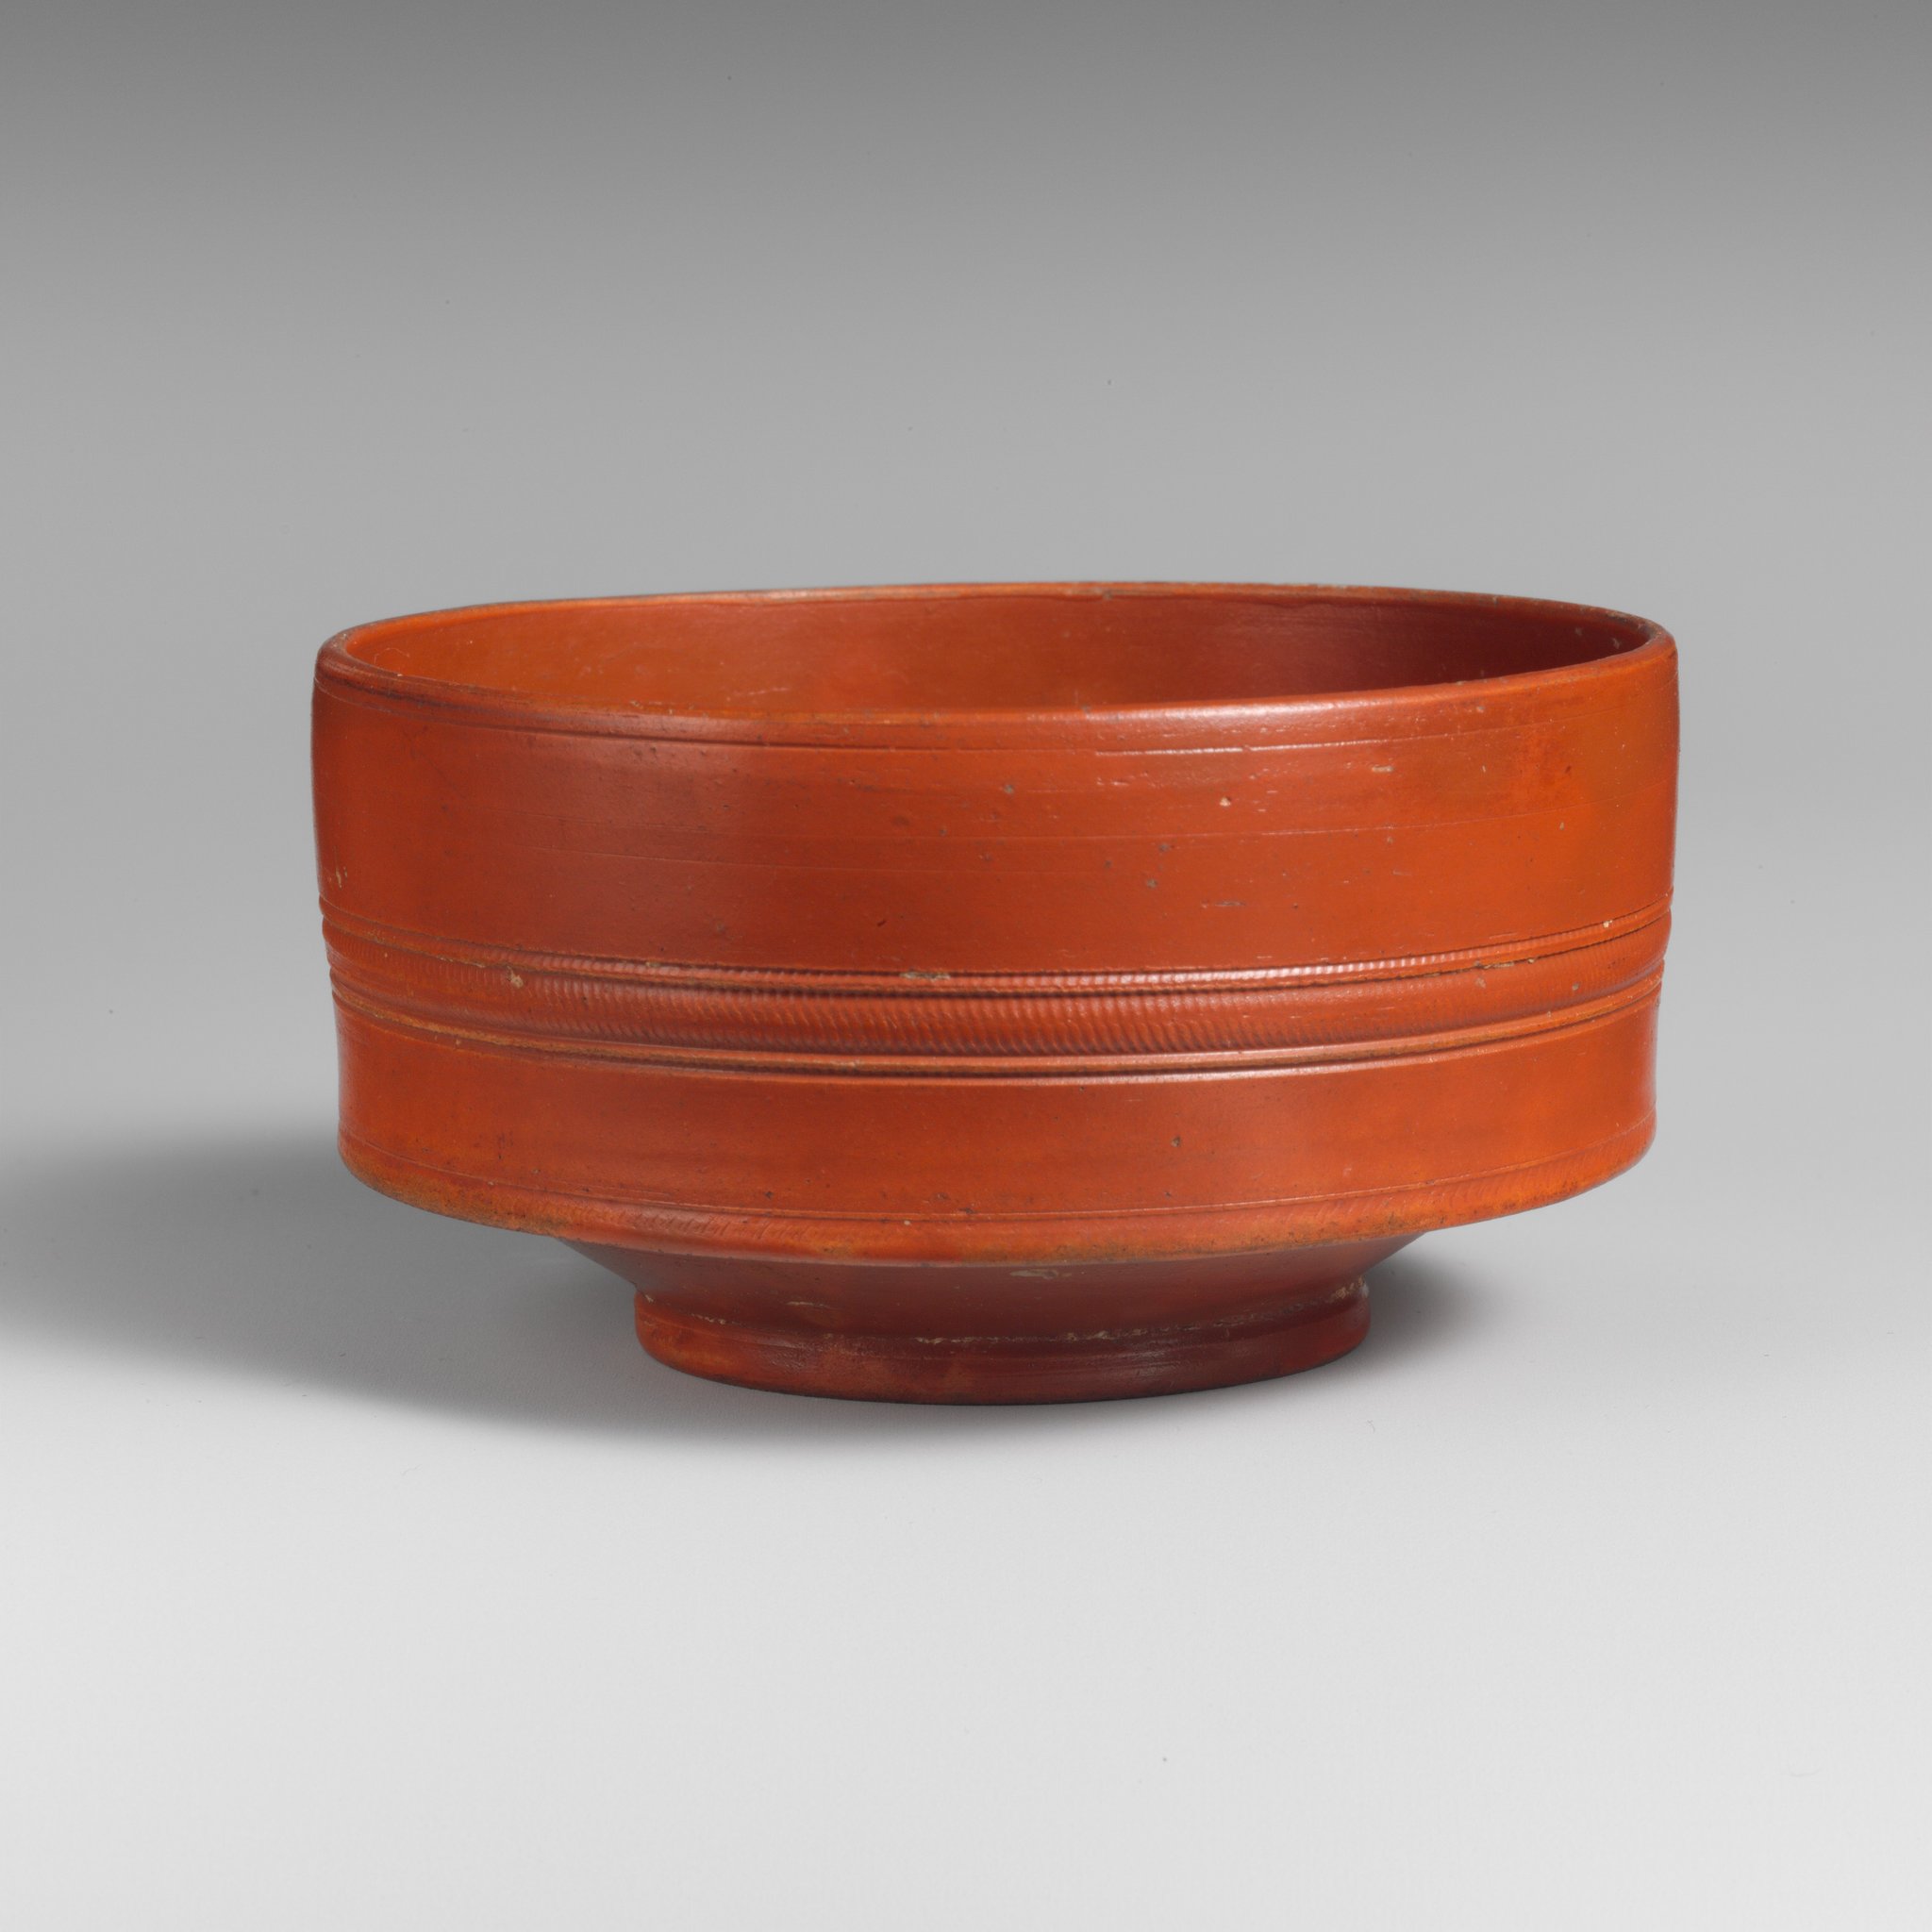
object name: cup with base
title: Terracotta bowl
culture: roman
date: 1-50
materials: terracotta